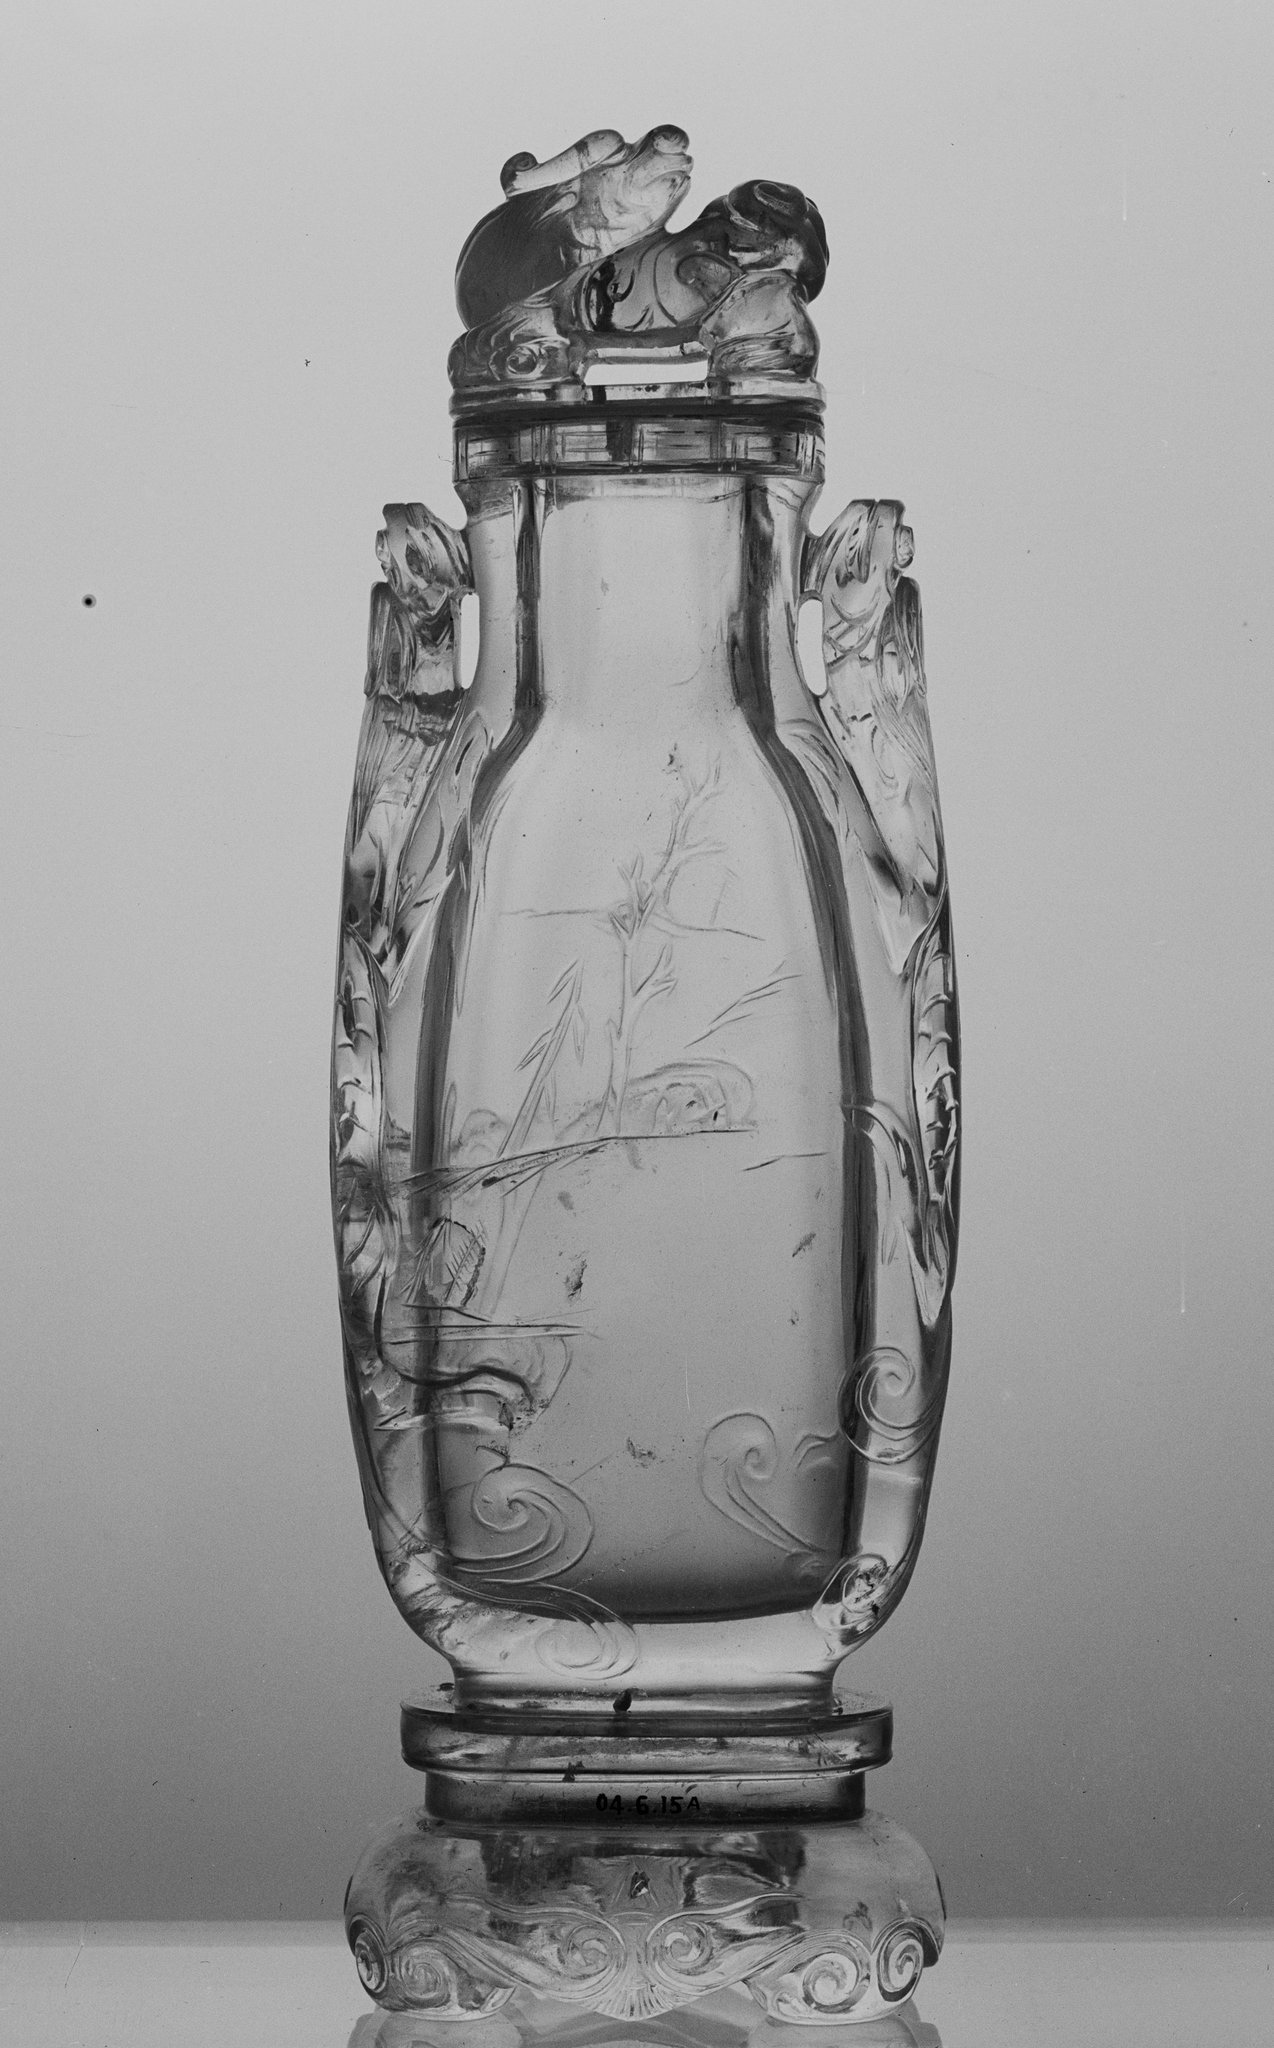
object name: flask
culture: chinese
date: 1801-1900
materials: quartz